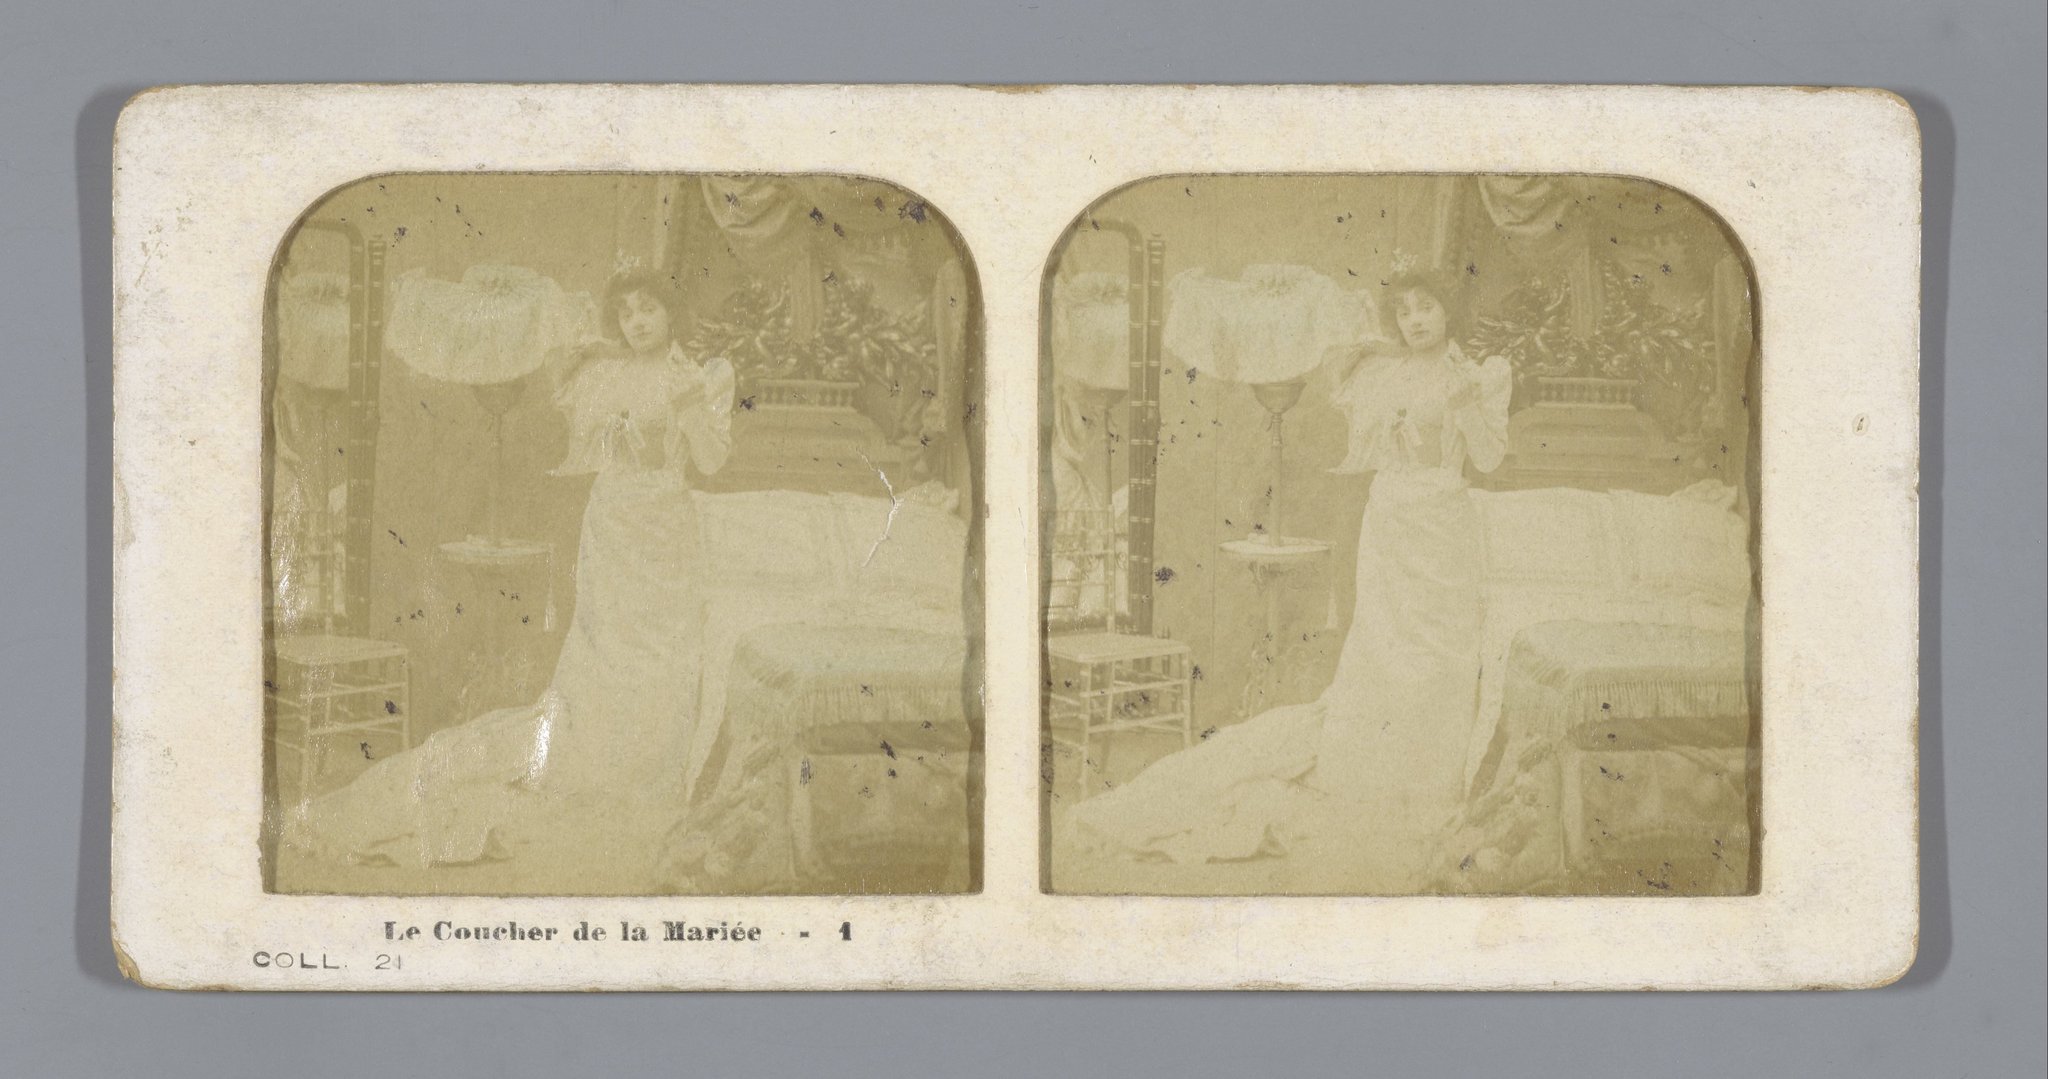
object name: tissue stereograph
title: Bruid voor de huwelijksnacht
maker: Anonymous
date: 1855-1905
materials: cardboard, paper, photographic support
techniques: albumen print, cutting, hand coloring, perforating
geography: france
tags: the wedding night, leading the bride to bed, france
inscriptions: inscription: ‘COLL. 21’, number: ‘1’